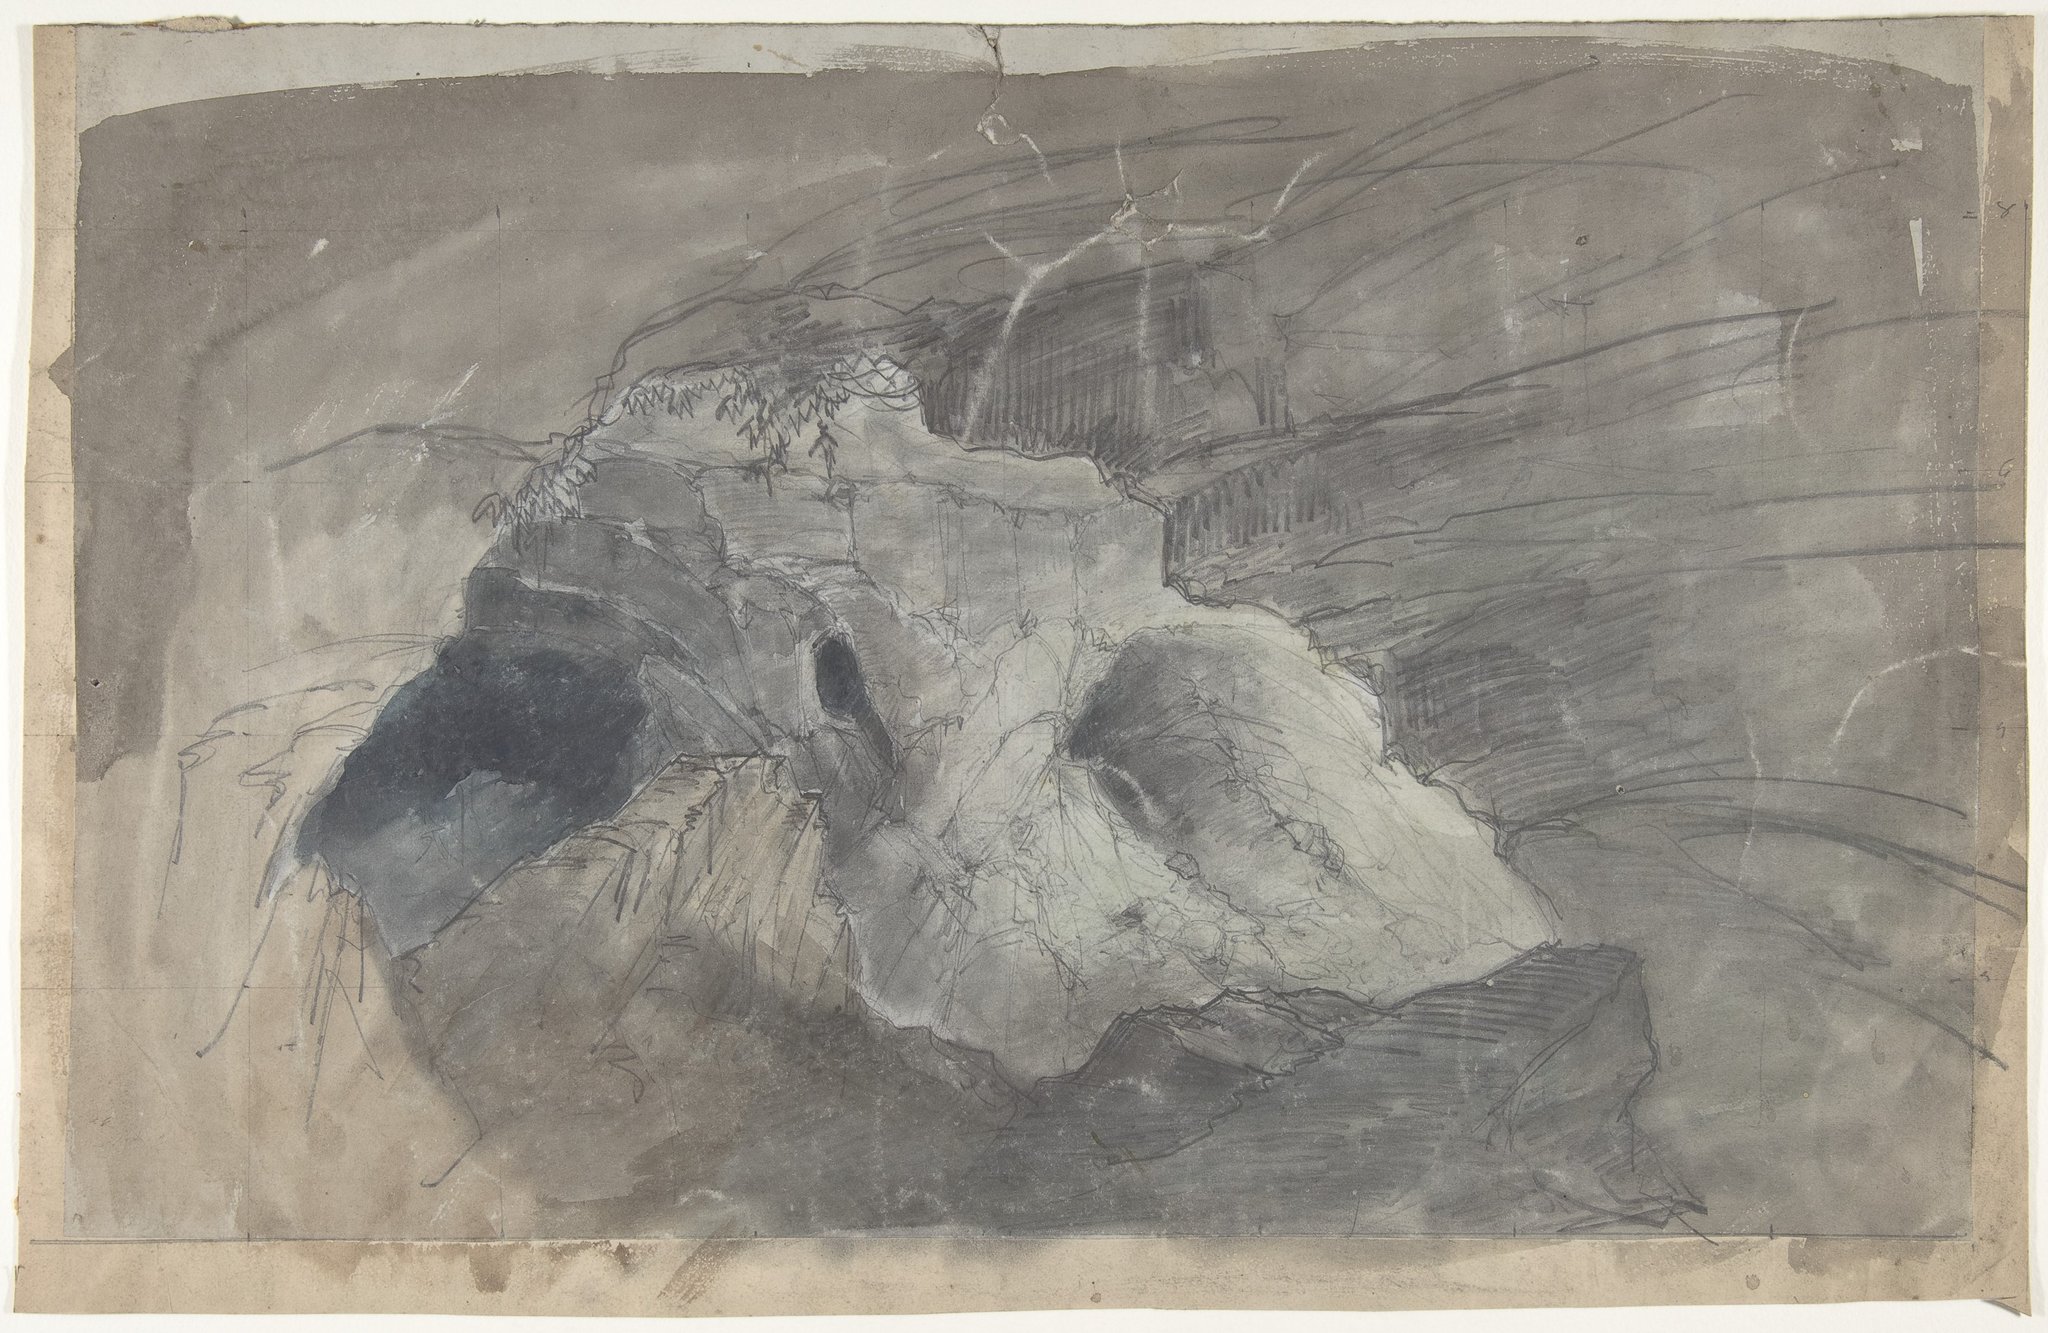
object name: drawing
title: Design for a Stage Set at the Opéra, Paris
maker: eugène cicéri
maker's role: artist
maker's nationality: french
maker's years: 1813-1890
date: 1828-1890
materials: graphite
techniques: brush, wash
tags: stage design